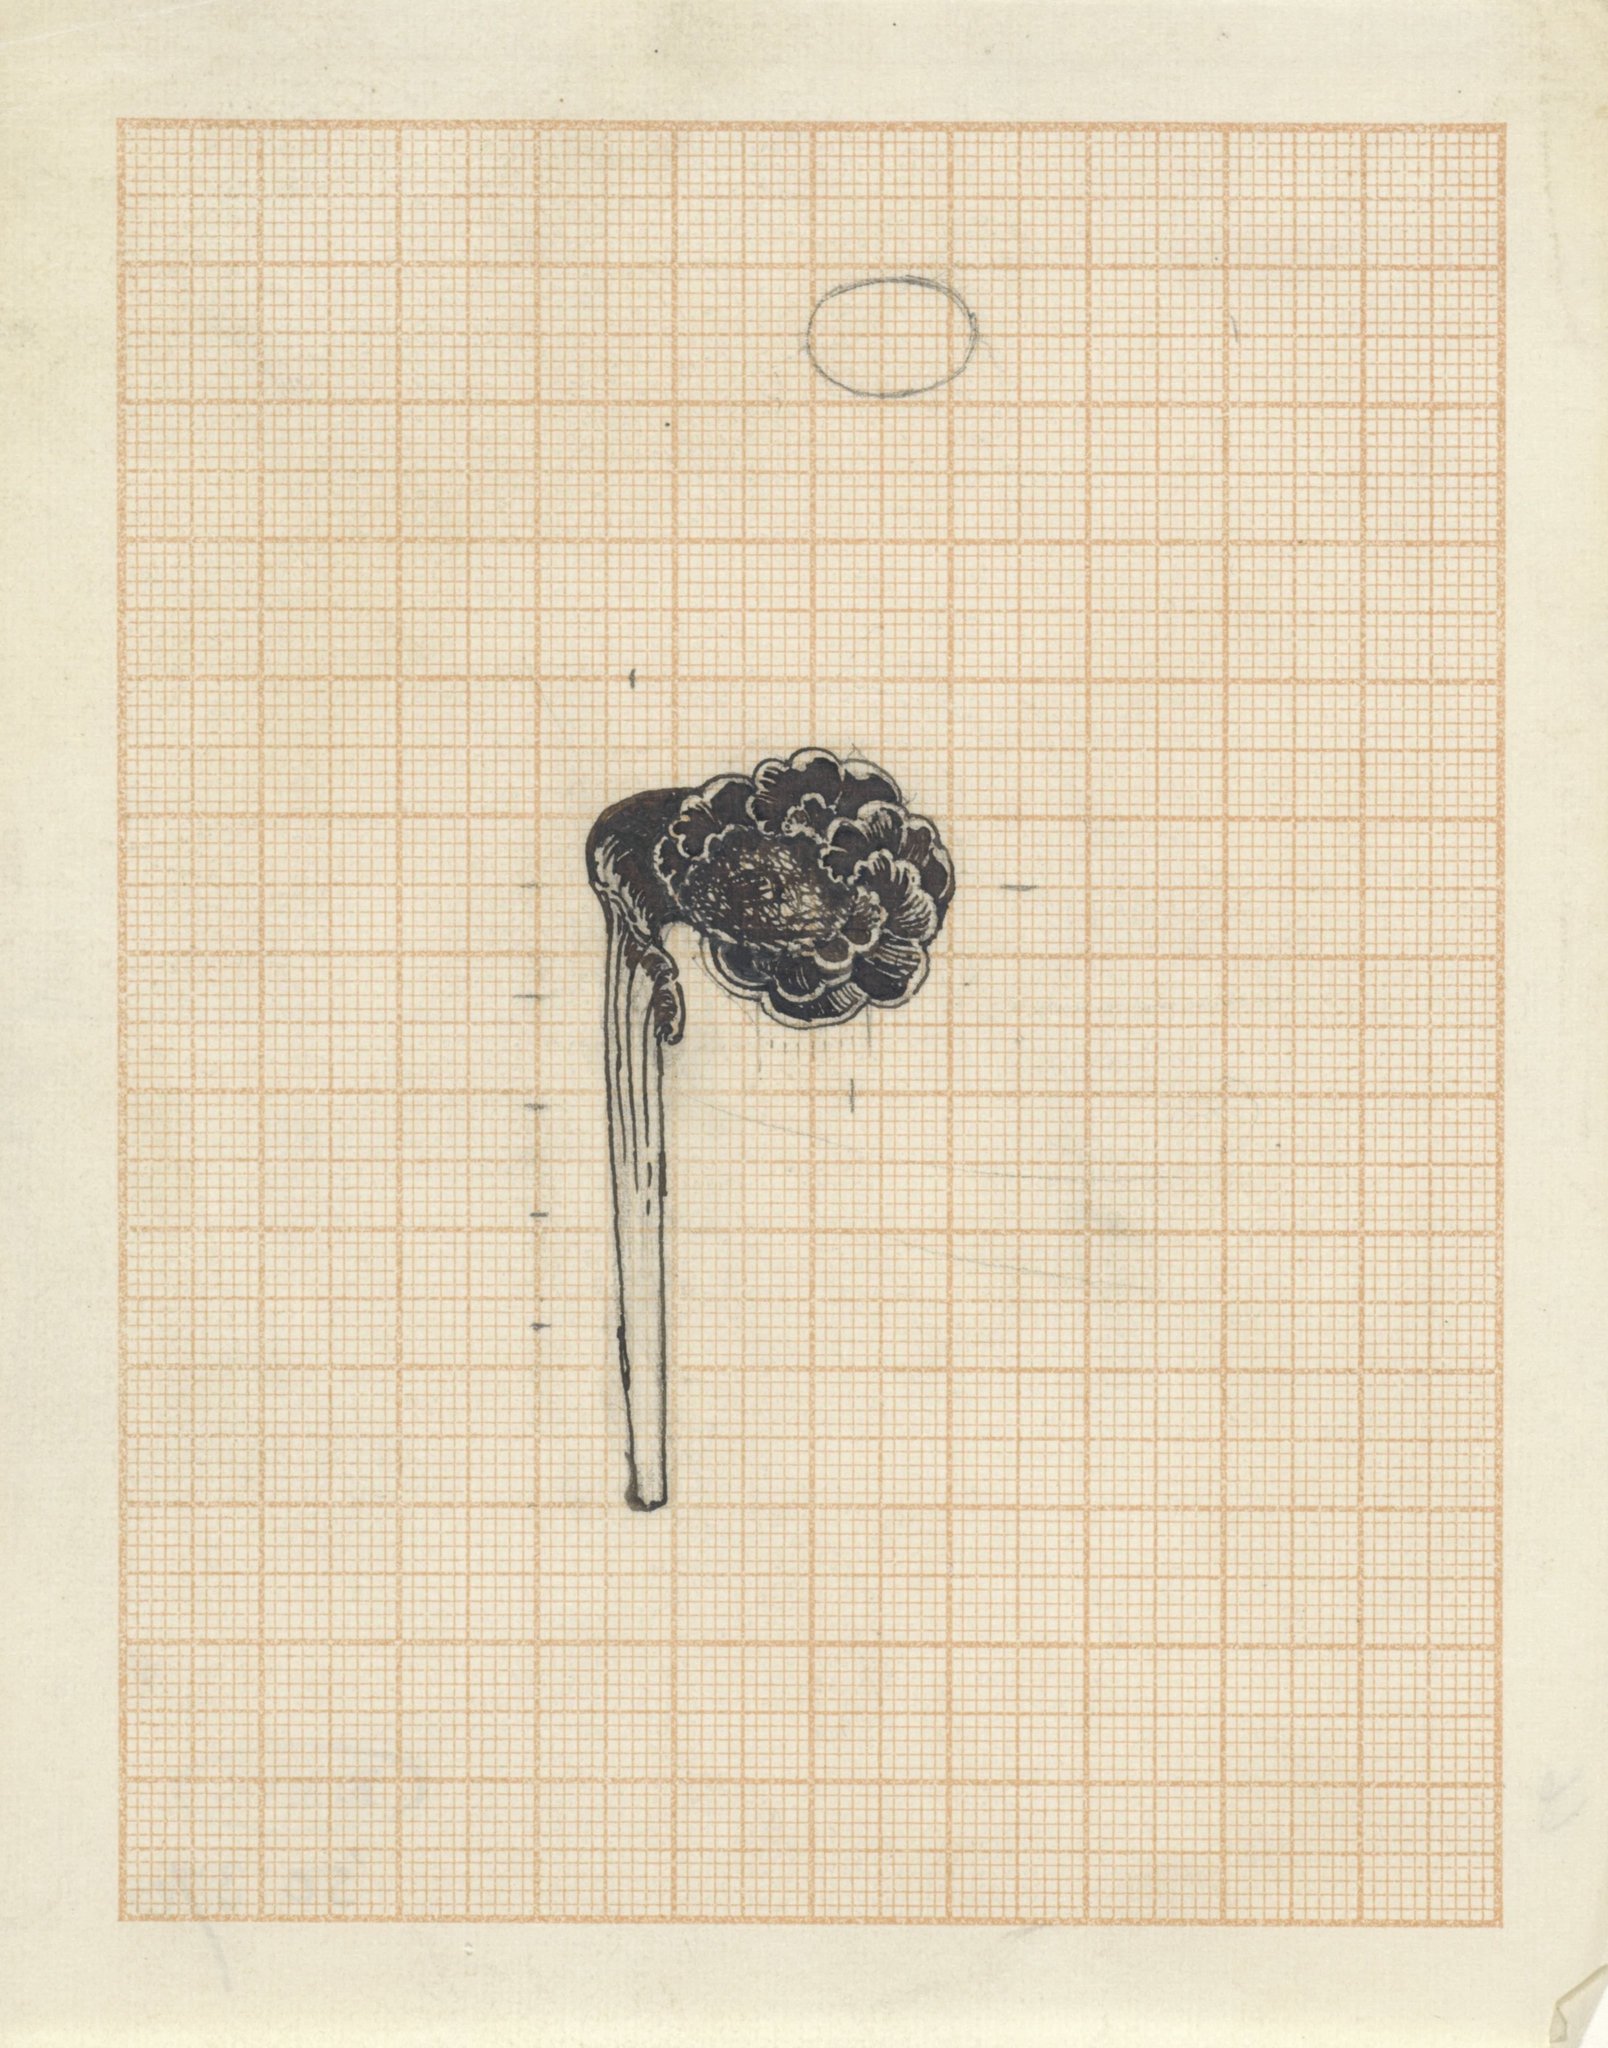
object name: design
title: Ontwerp voor een sieraad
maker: mathieu lauweriks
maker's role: designer, draughtsman, print maker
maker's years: 1864-1932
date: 1874-1932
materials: ink, pencil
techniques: pen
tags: ornaments, jewels